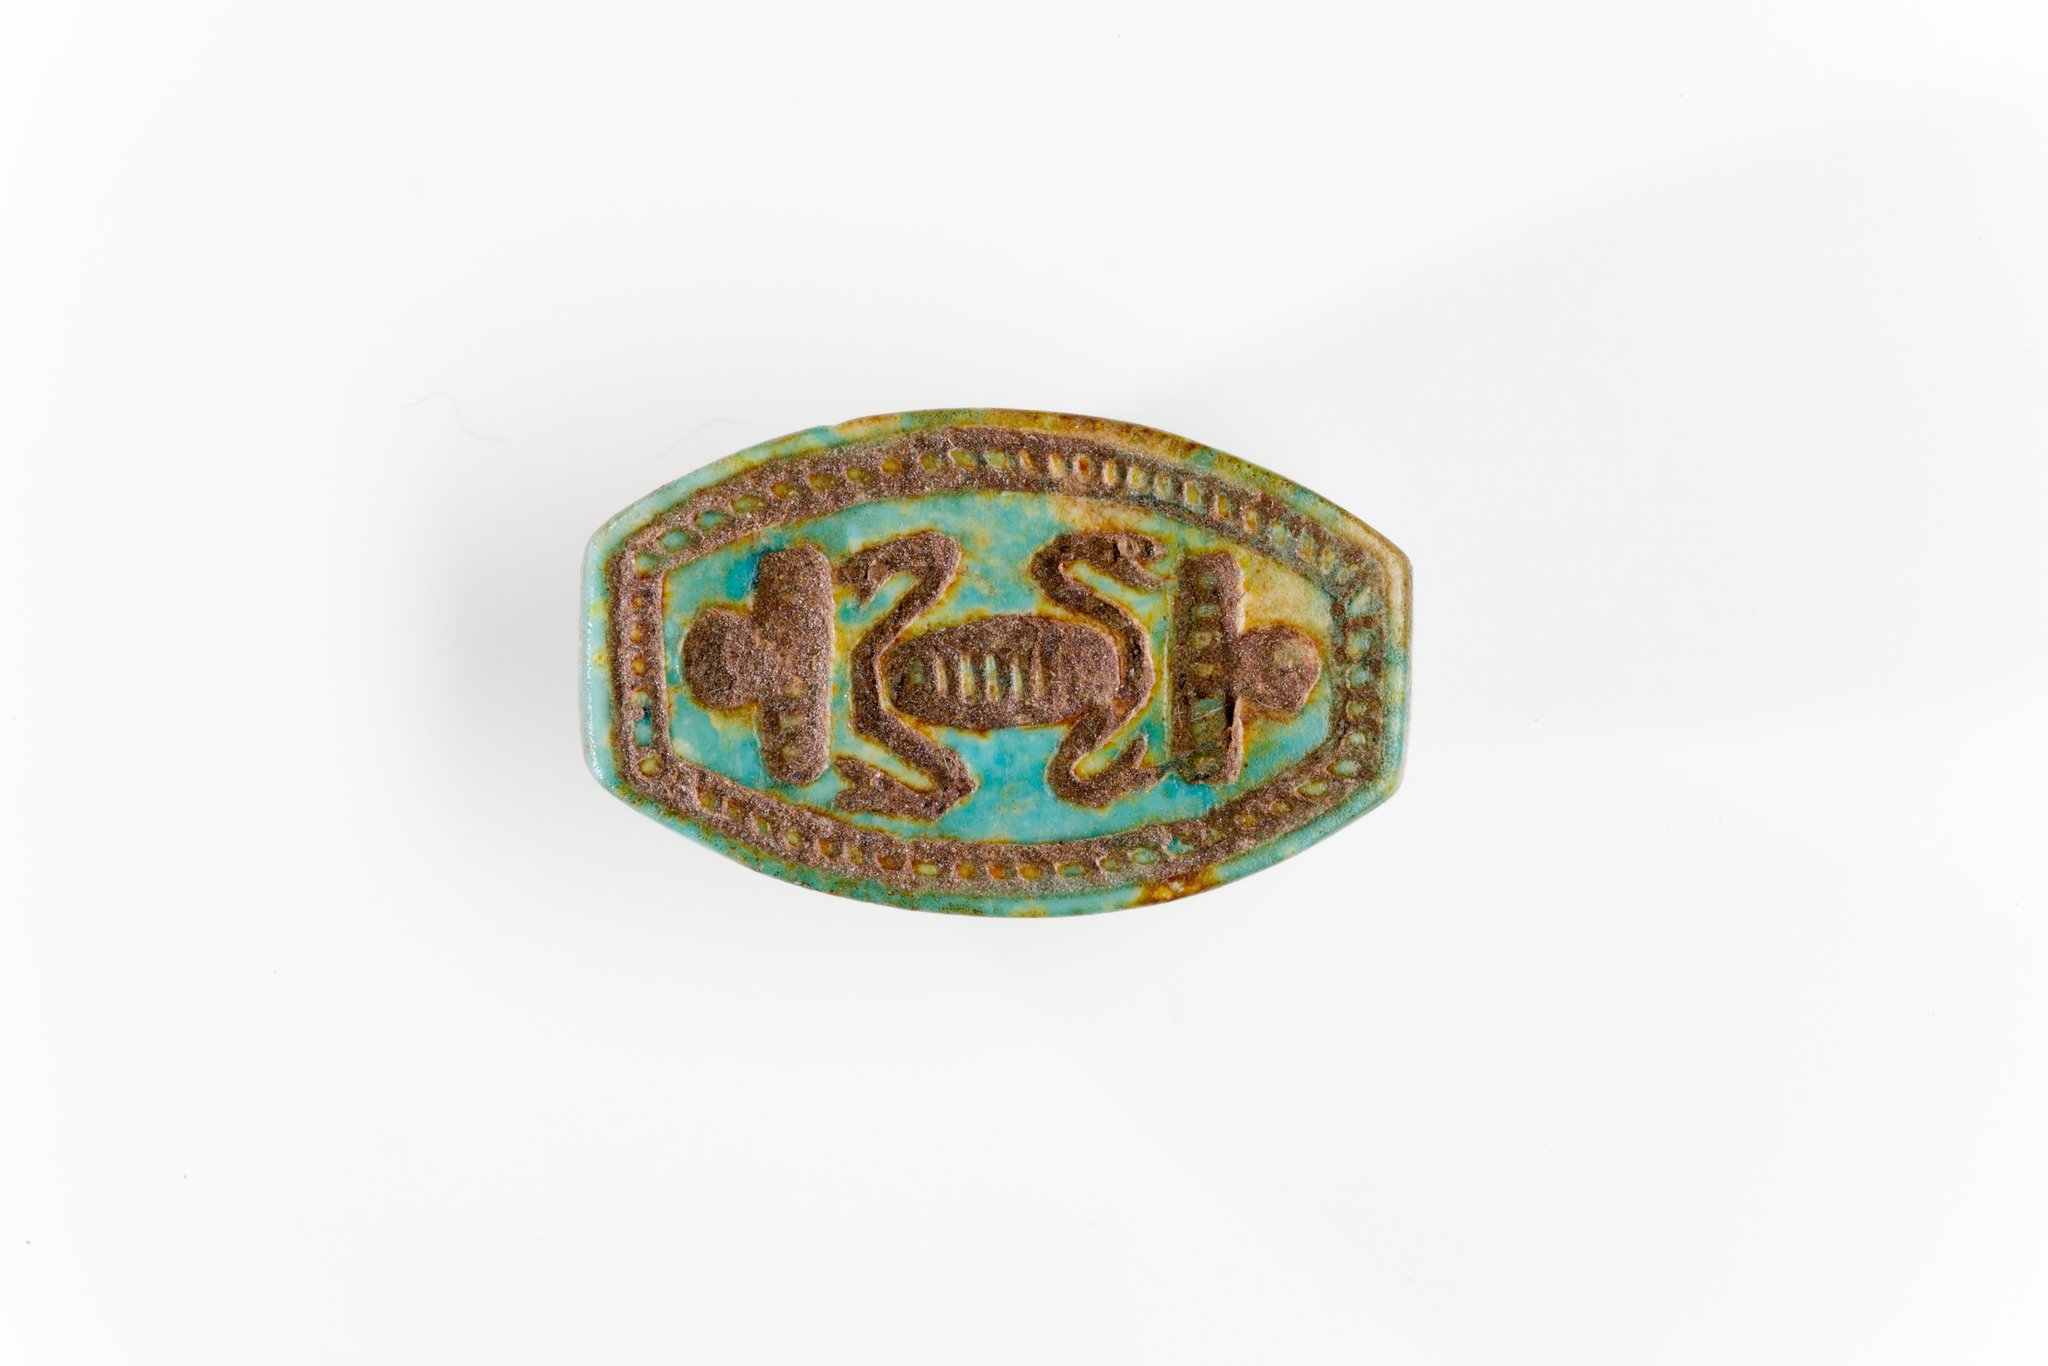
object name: cowroid, hetep, frog, lizard, rennefer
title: Cowroid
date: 1504-1447 BCE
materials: faience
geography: egypt